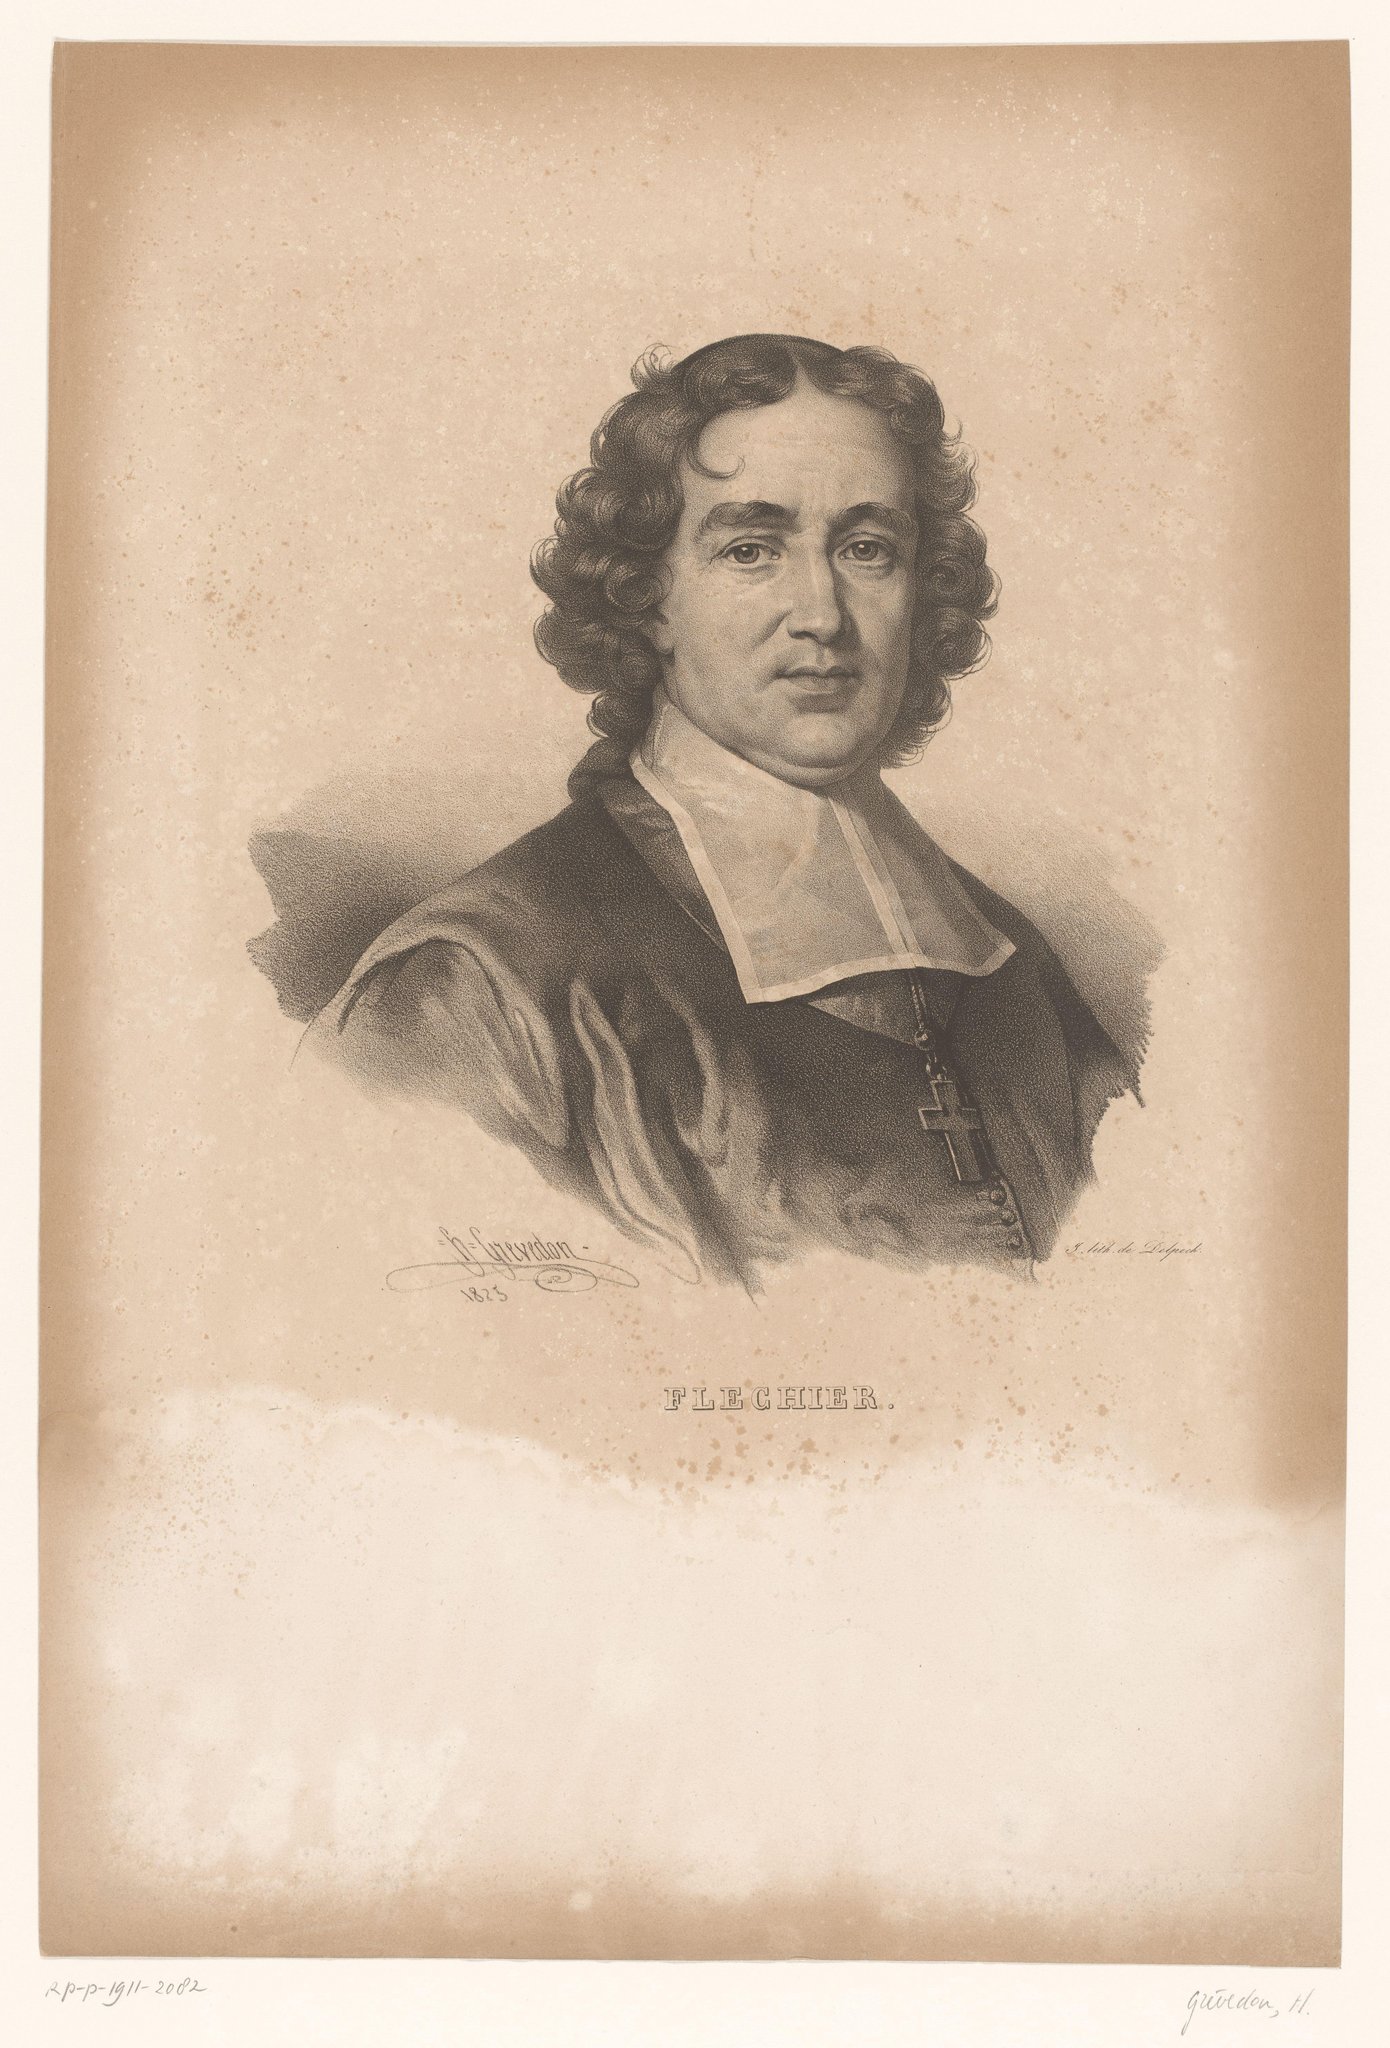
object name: print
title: Les Orateurs chrétiens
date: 1825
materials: paper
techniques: lithograph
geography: paris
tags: priest, historical persons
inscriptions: collector's mark: Lugt 2228a